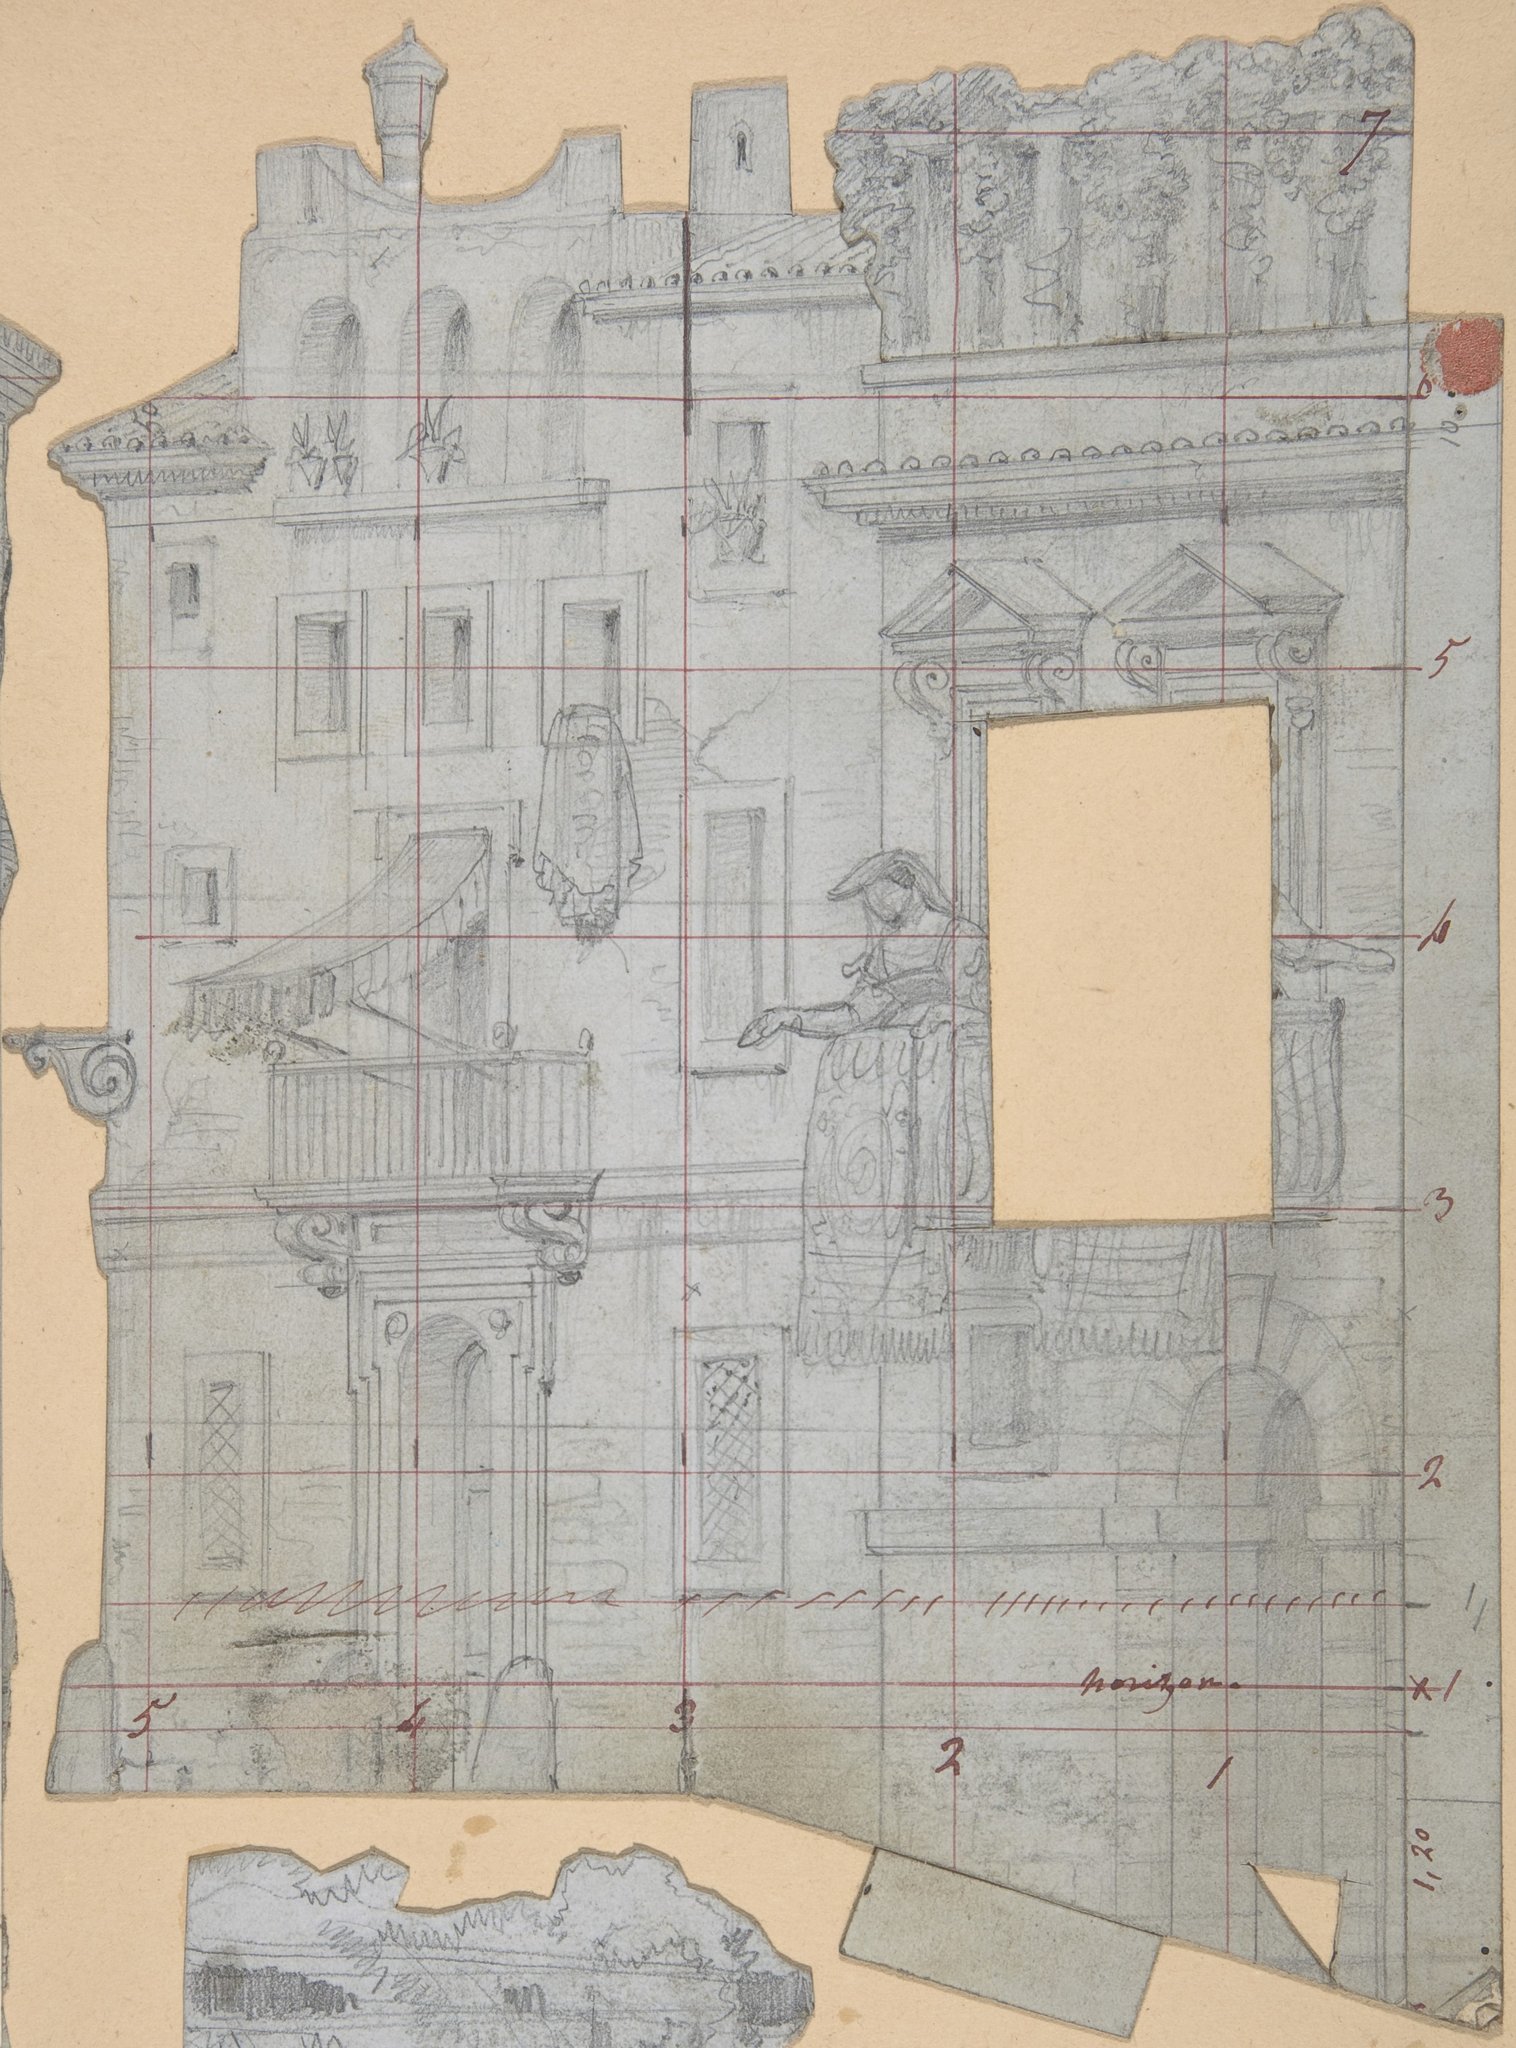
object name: drawing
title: Design for a Stage Set at the Opéra, Paris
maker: eugène cicéri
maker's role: artist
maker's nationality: french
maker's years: 1813-1890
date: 1830-1890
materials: graphite, ink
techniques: pen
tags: buildings,stage design